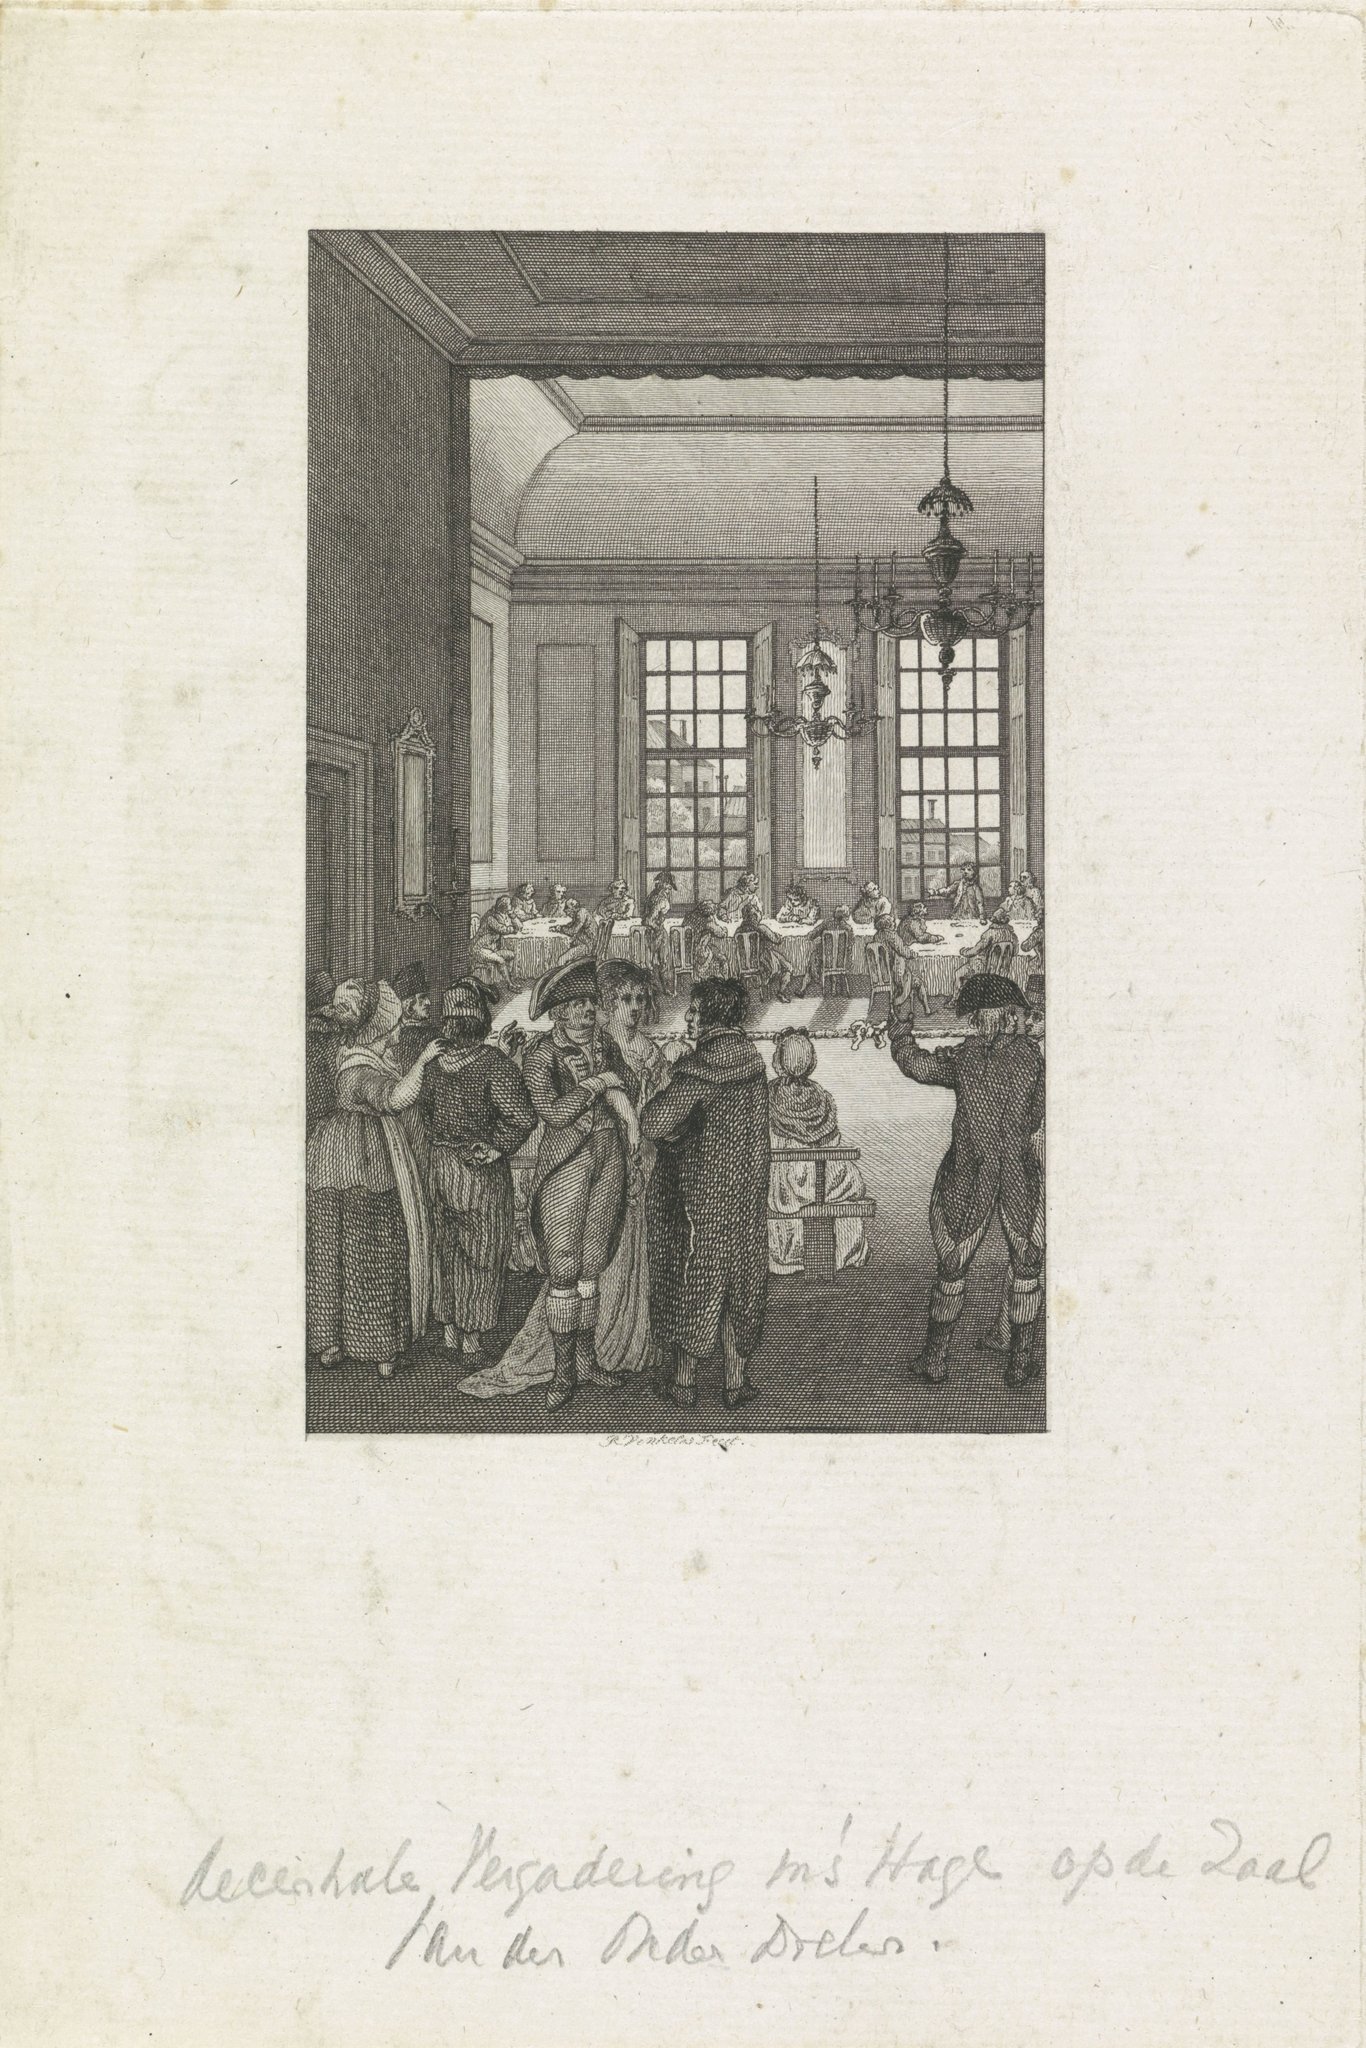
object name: print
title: Algemene Centrale Vergadering in Den Haag, 1795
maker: reinier vinkeles (i)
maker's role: draughtsman, print maker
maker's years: 1741-1816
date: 1803-1805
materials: paper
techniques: engraving, etching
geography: netherlands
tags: national government, politics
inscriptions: collector's mark: Lugt 2228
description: Gebruikt als illustratie in: P.A. Loosjes. Vaderlandsche historie, vervattende de geschiedenissen, der Vereenigde Nederlanden (...). Ten onmiddelyken vervolge van Wagenaar's Vaderlandsche historie. Amsterdam: Johannes Allart, dl. 34 (1805).